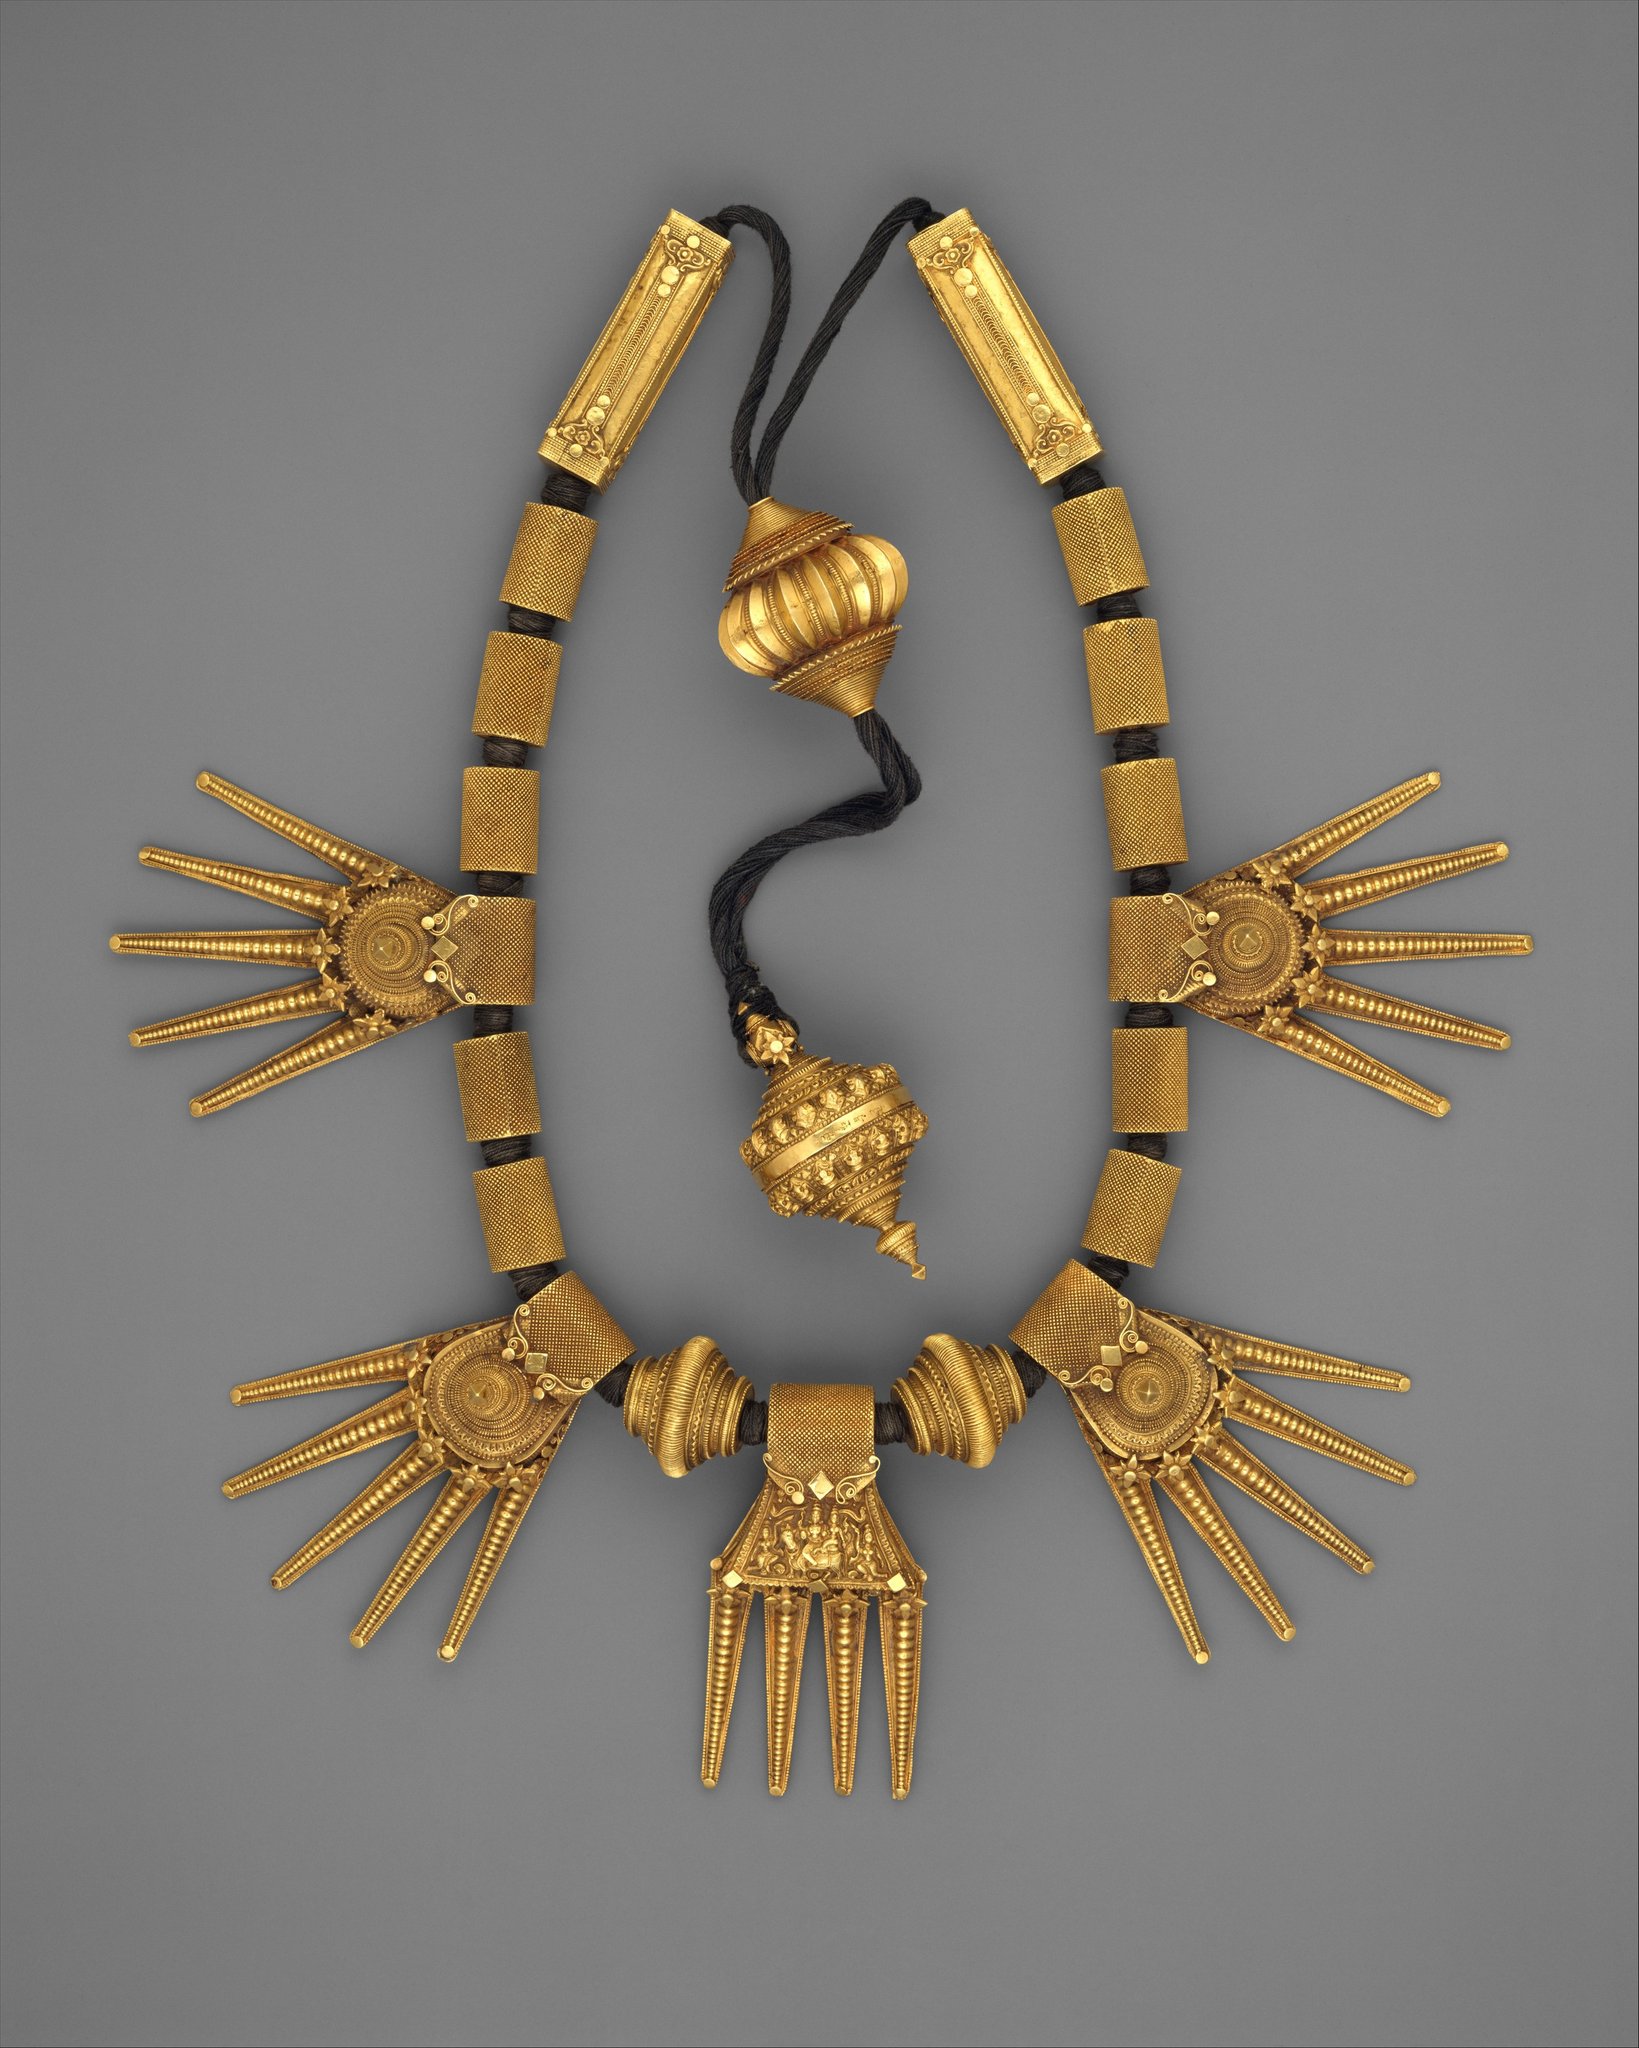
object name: necklace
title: Marriage Necklace (Thali)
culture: indian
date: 1867-1900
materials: gold, thread